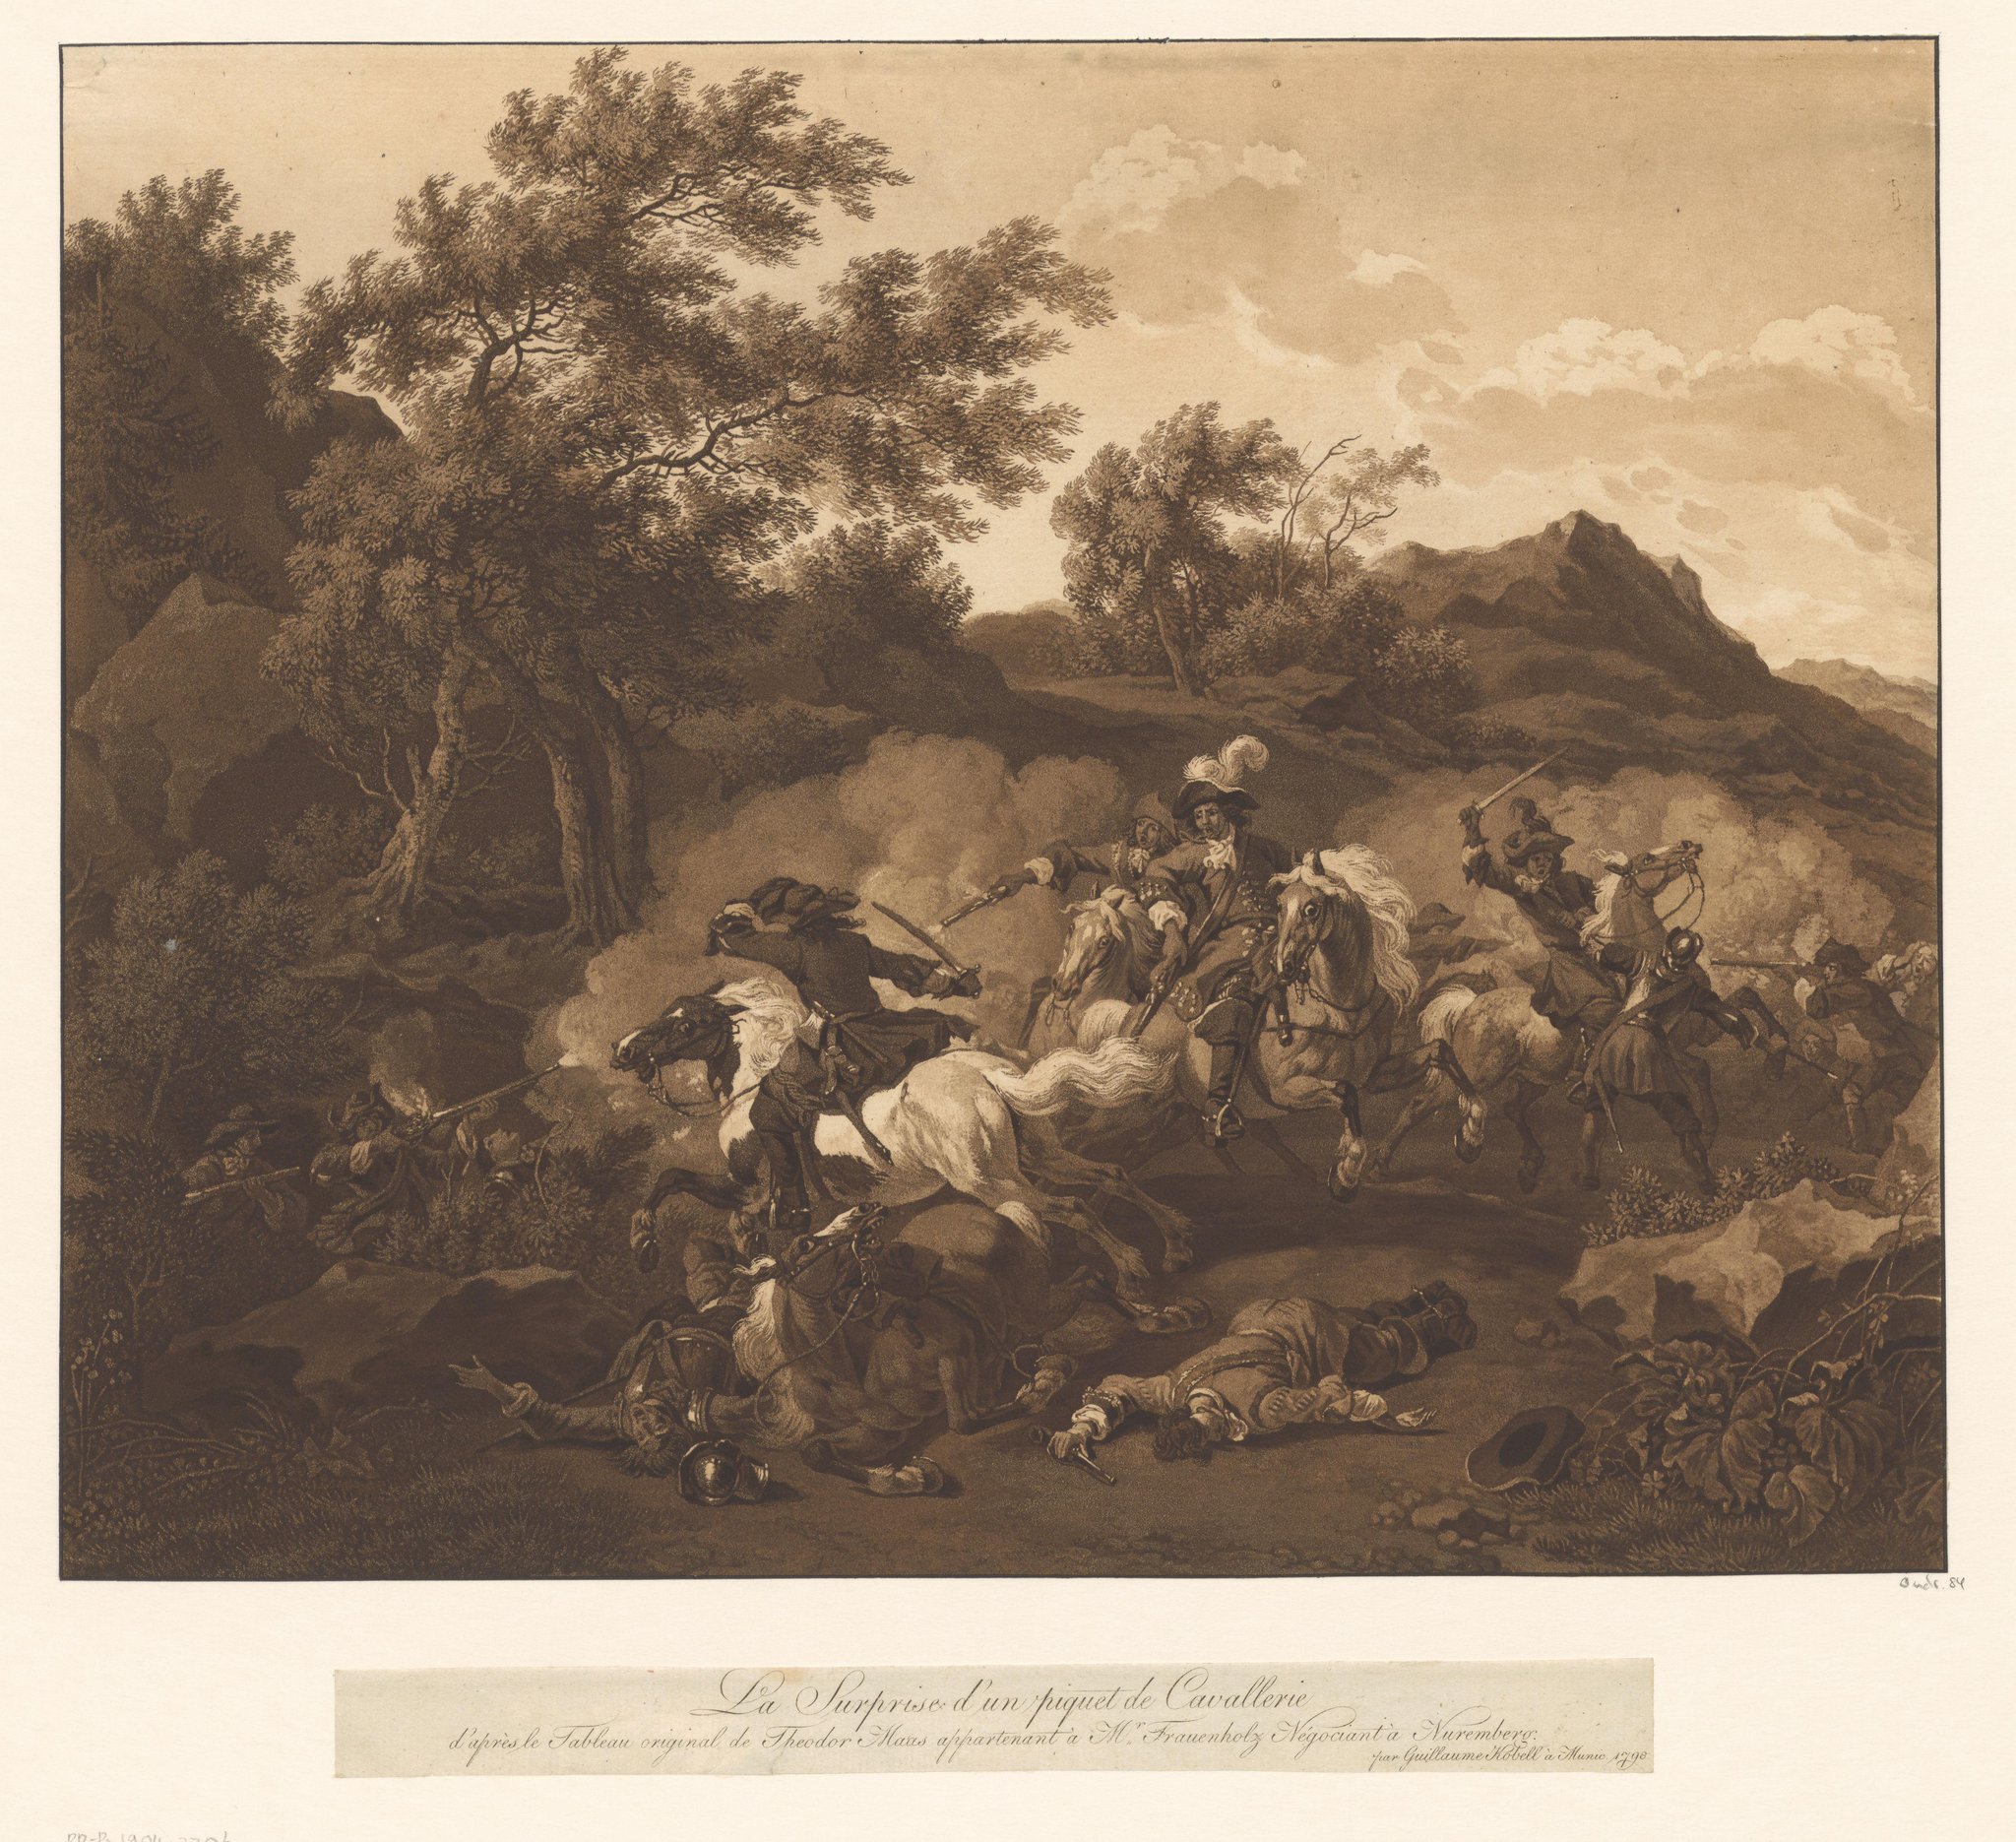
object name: print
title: La surprise d'un piquet de Cavallerie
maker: wilhelm alexander wolfgang von kobell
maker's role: print maker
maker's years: 1766-1855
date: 1798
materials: paper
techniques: aquatint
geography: munich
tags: riding a horse, ass, or mule; rider, horseman, low hill country, surprise attack (from ambush)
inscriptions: collector's mark: Lugt 2228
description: Een losse strook met tekst in het Frans is onder prent op het opzetvel geplakt. Hierop staat dat de prent gemaakt is naar een schilderij door Theodor Maas uit de collectie van Johann Friedrich Frauenholz (1758-1822) kunstverkoper in Neurenberg.